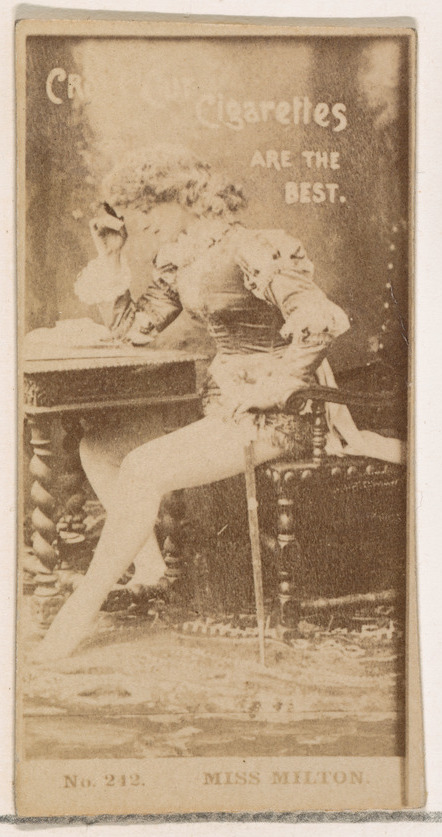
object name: print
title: Card Number 242, Miss Milton, from the Actors and Actresses series (N145-2) issued by Duke Sons & Co. to promote Cross Cut Cigarettes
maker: w. duke, sons & co.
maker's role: publisher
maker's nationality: american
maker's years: 1870-1920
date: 1880-1889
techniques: albumen silver print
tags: women,actresses